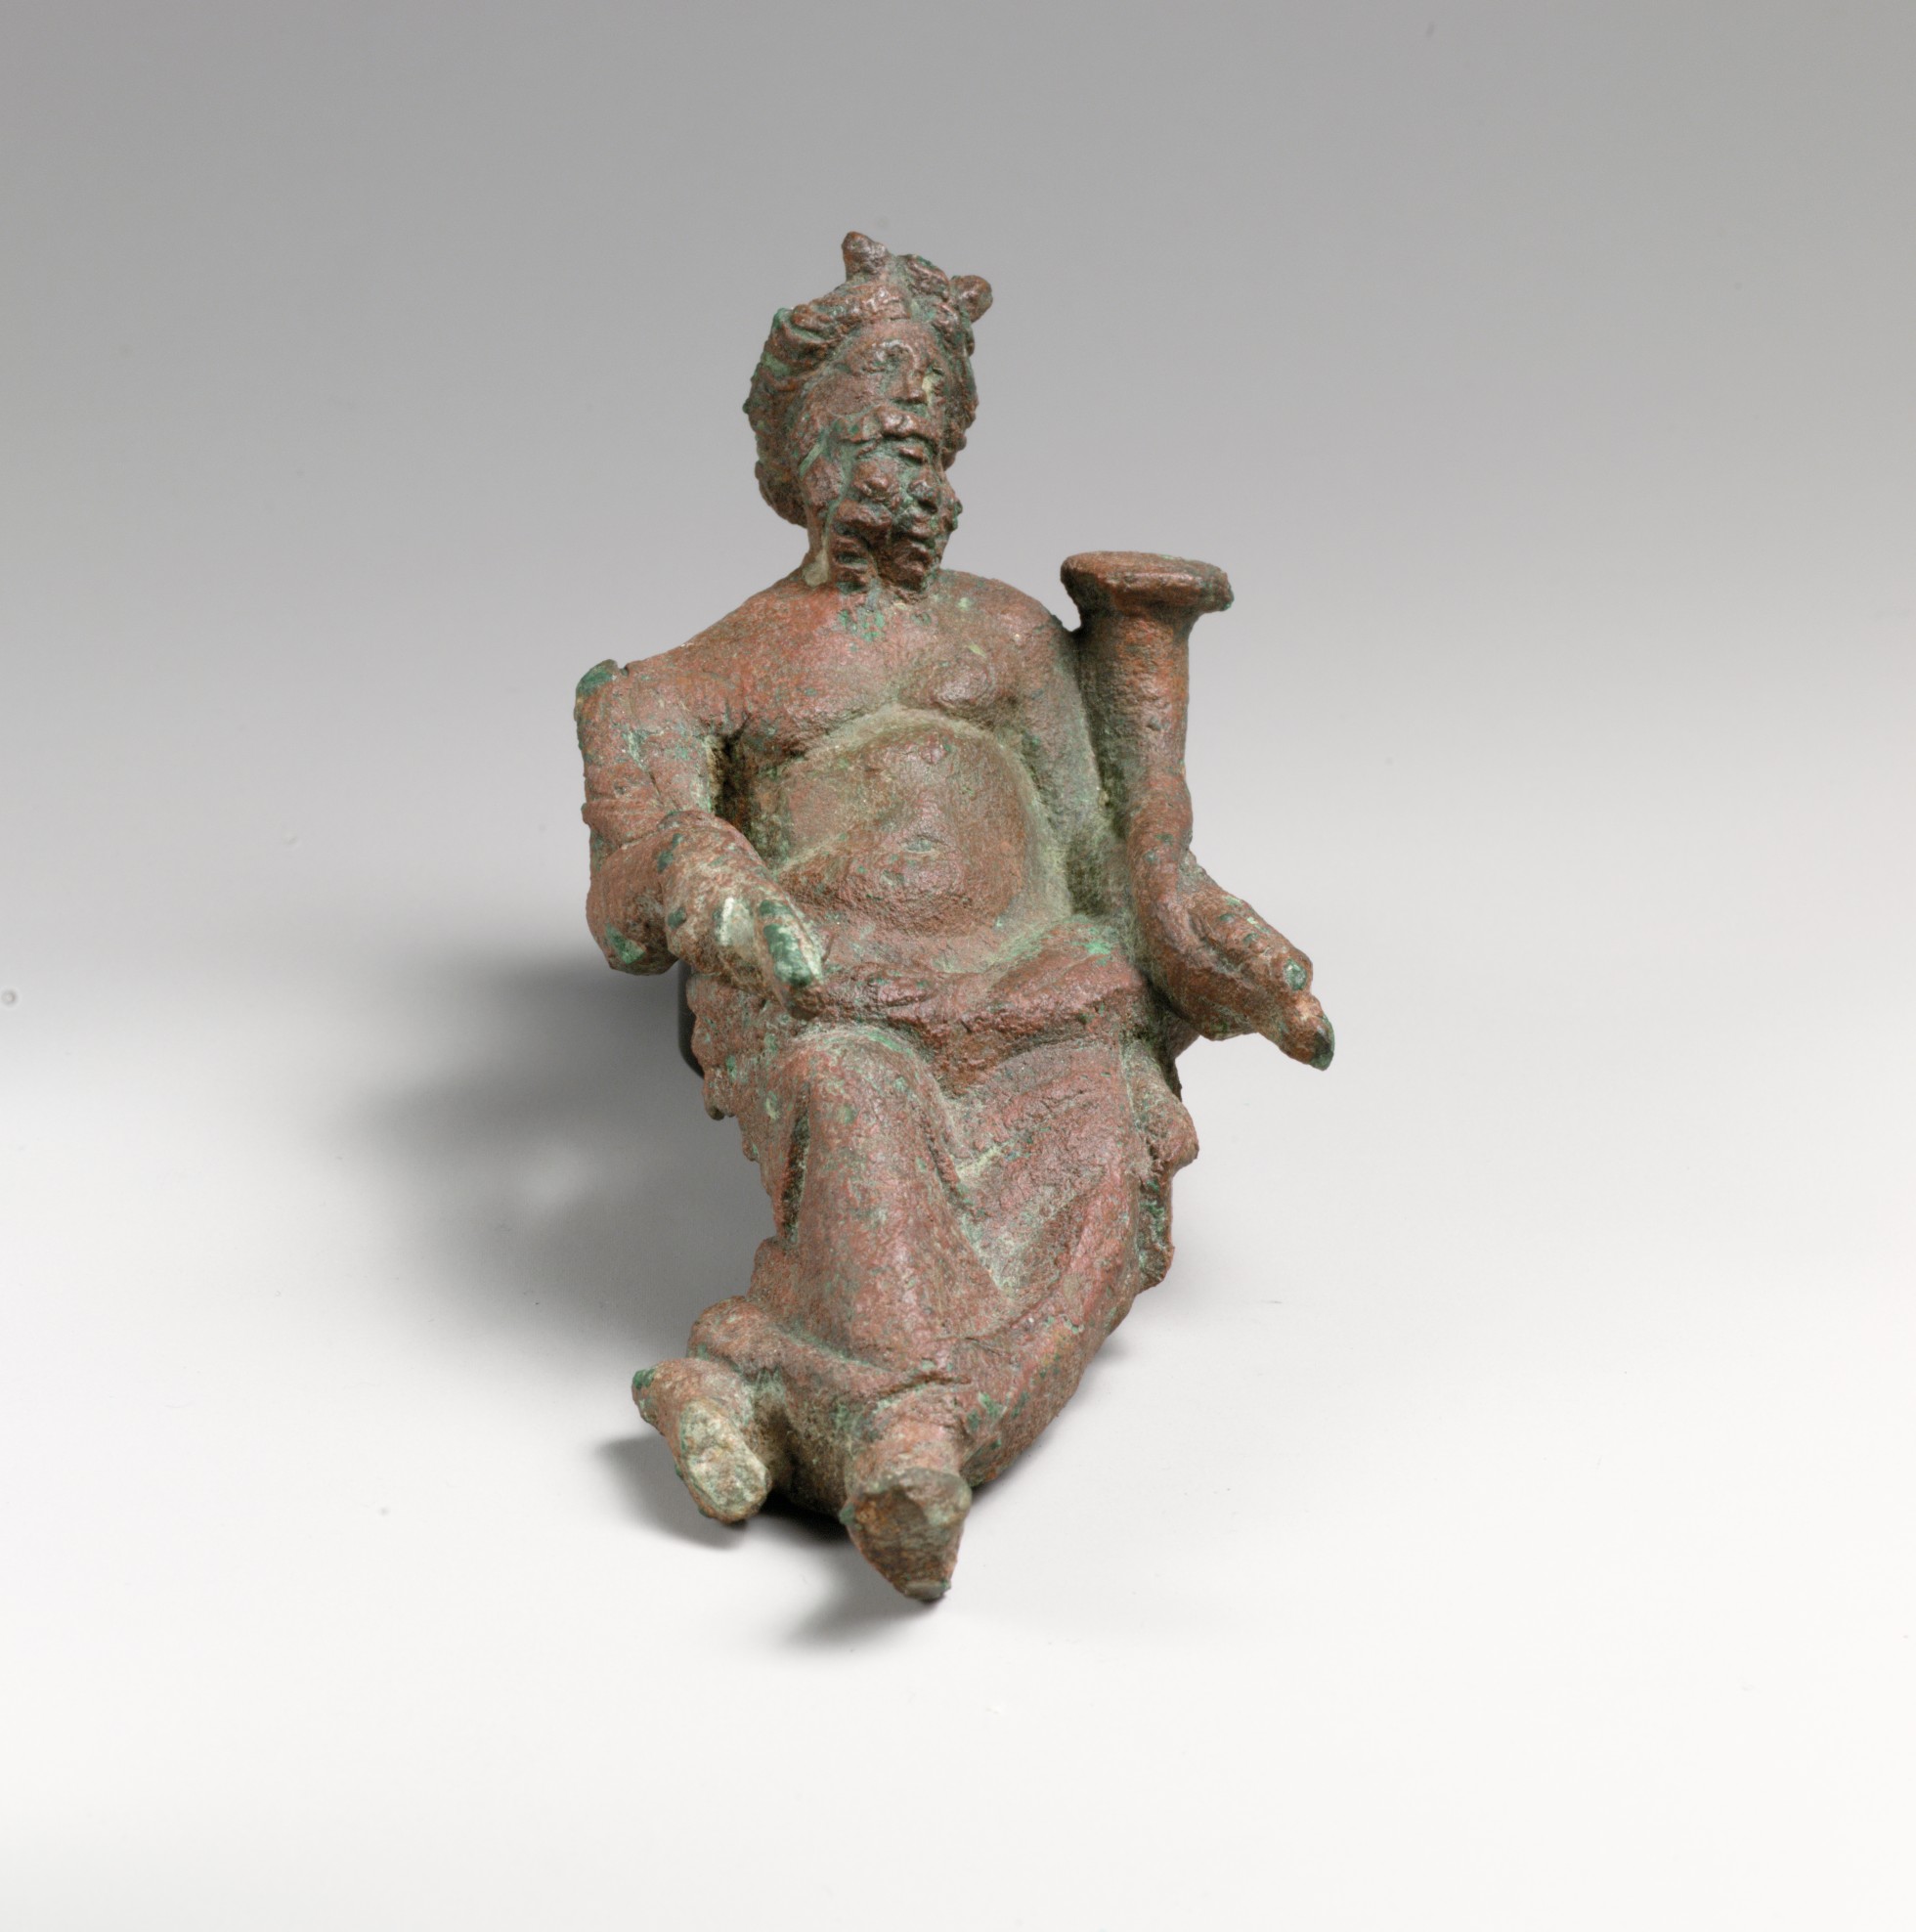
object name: statuette of a god with cornucopia, relief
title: Bronze statuette of a god holding a cornucopia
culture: greek or roman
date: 100 BCE-100 CE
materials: bronze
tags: men,gods